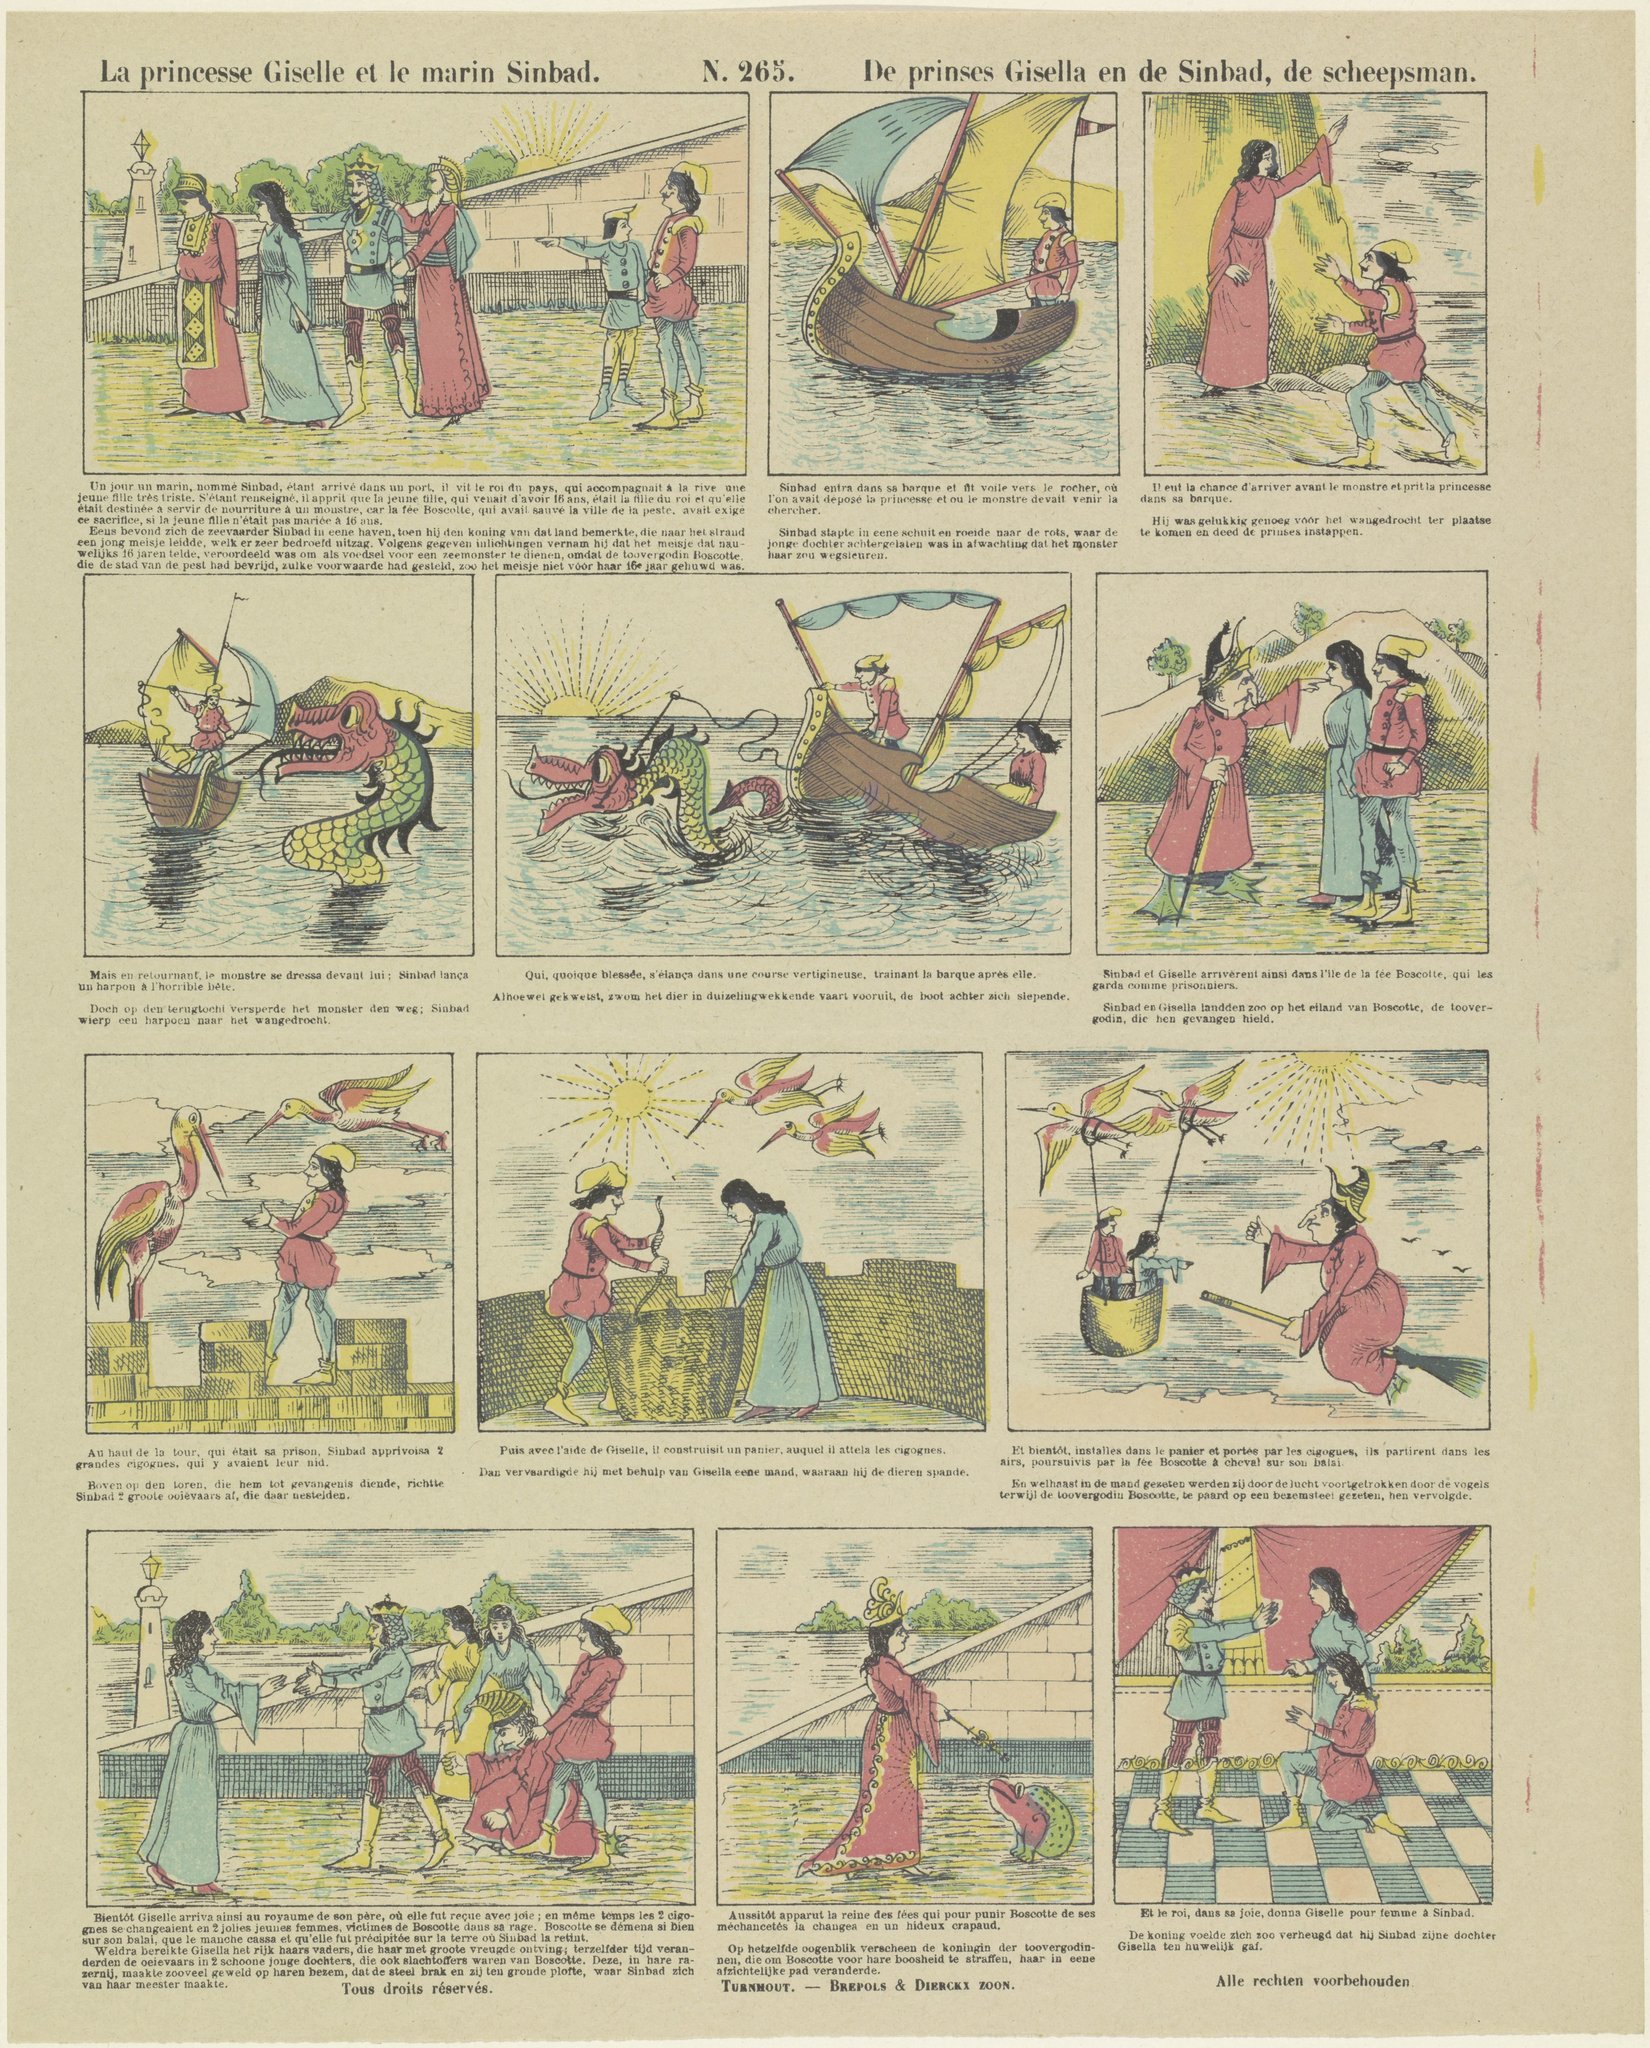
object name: print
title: La princesse Giselle et le marin Sinbad / De prinses Gisella en de Sinbad, de scheepsman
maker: Anonymous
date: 1833-1911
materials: paper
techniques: lithograph, letterpress printing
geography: turnhout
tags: monsters of the sea, princess, tales and fairy tales, seaman: sailor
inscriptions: collector's mark: Lugt 2760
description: Blad met 12 voorstellingen over prinses Gisella en Sinbad de zeeman. Onder elke afbeelding een onderschrift in het Nederlands en in het Frans. Genummerd midden boven: N. 265.